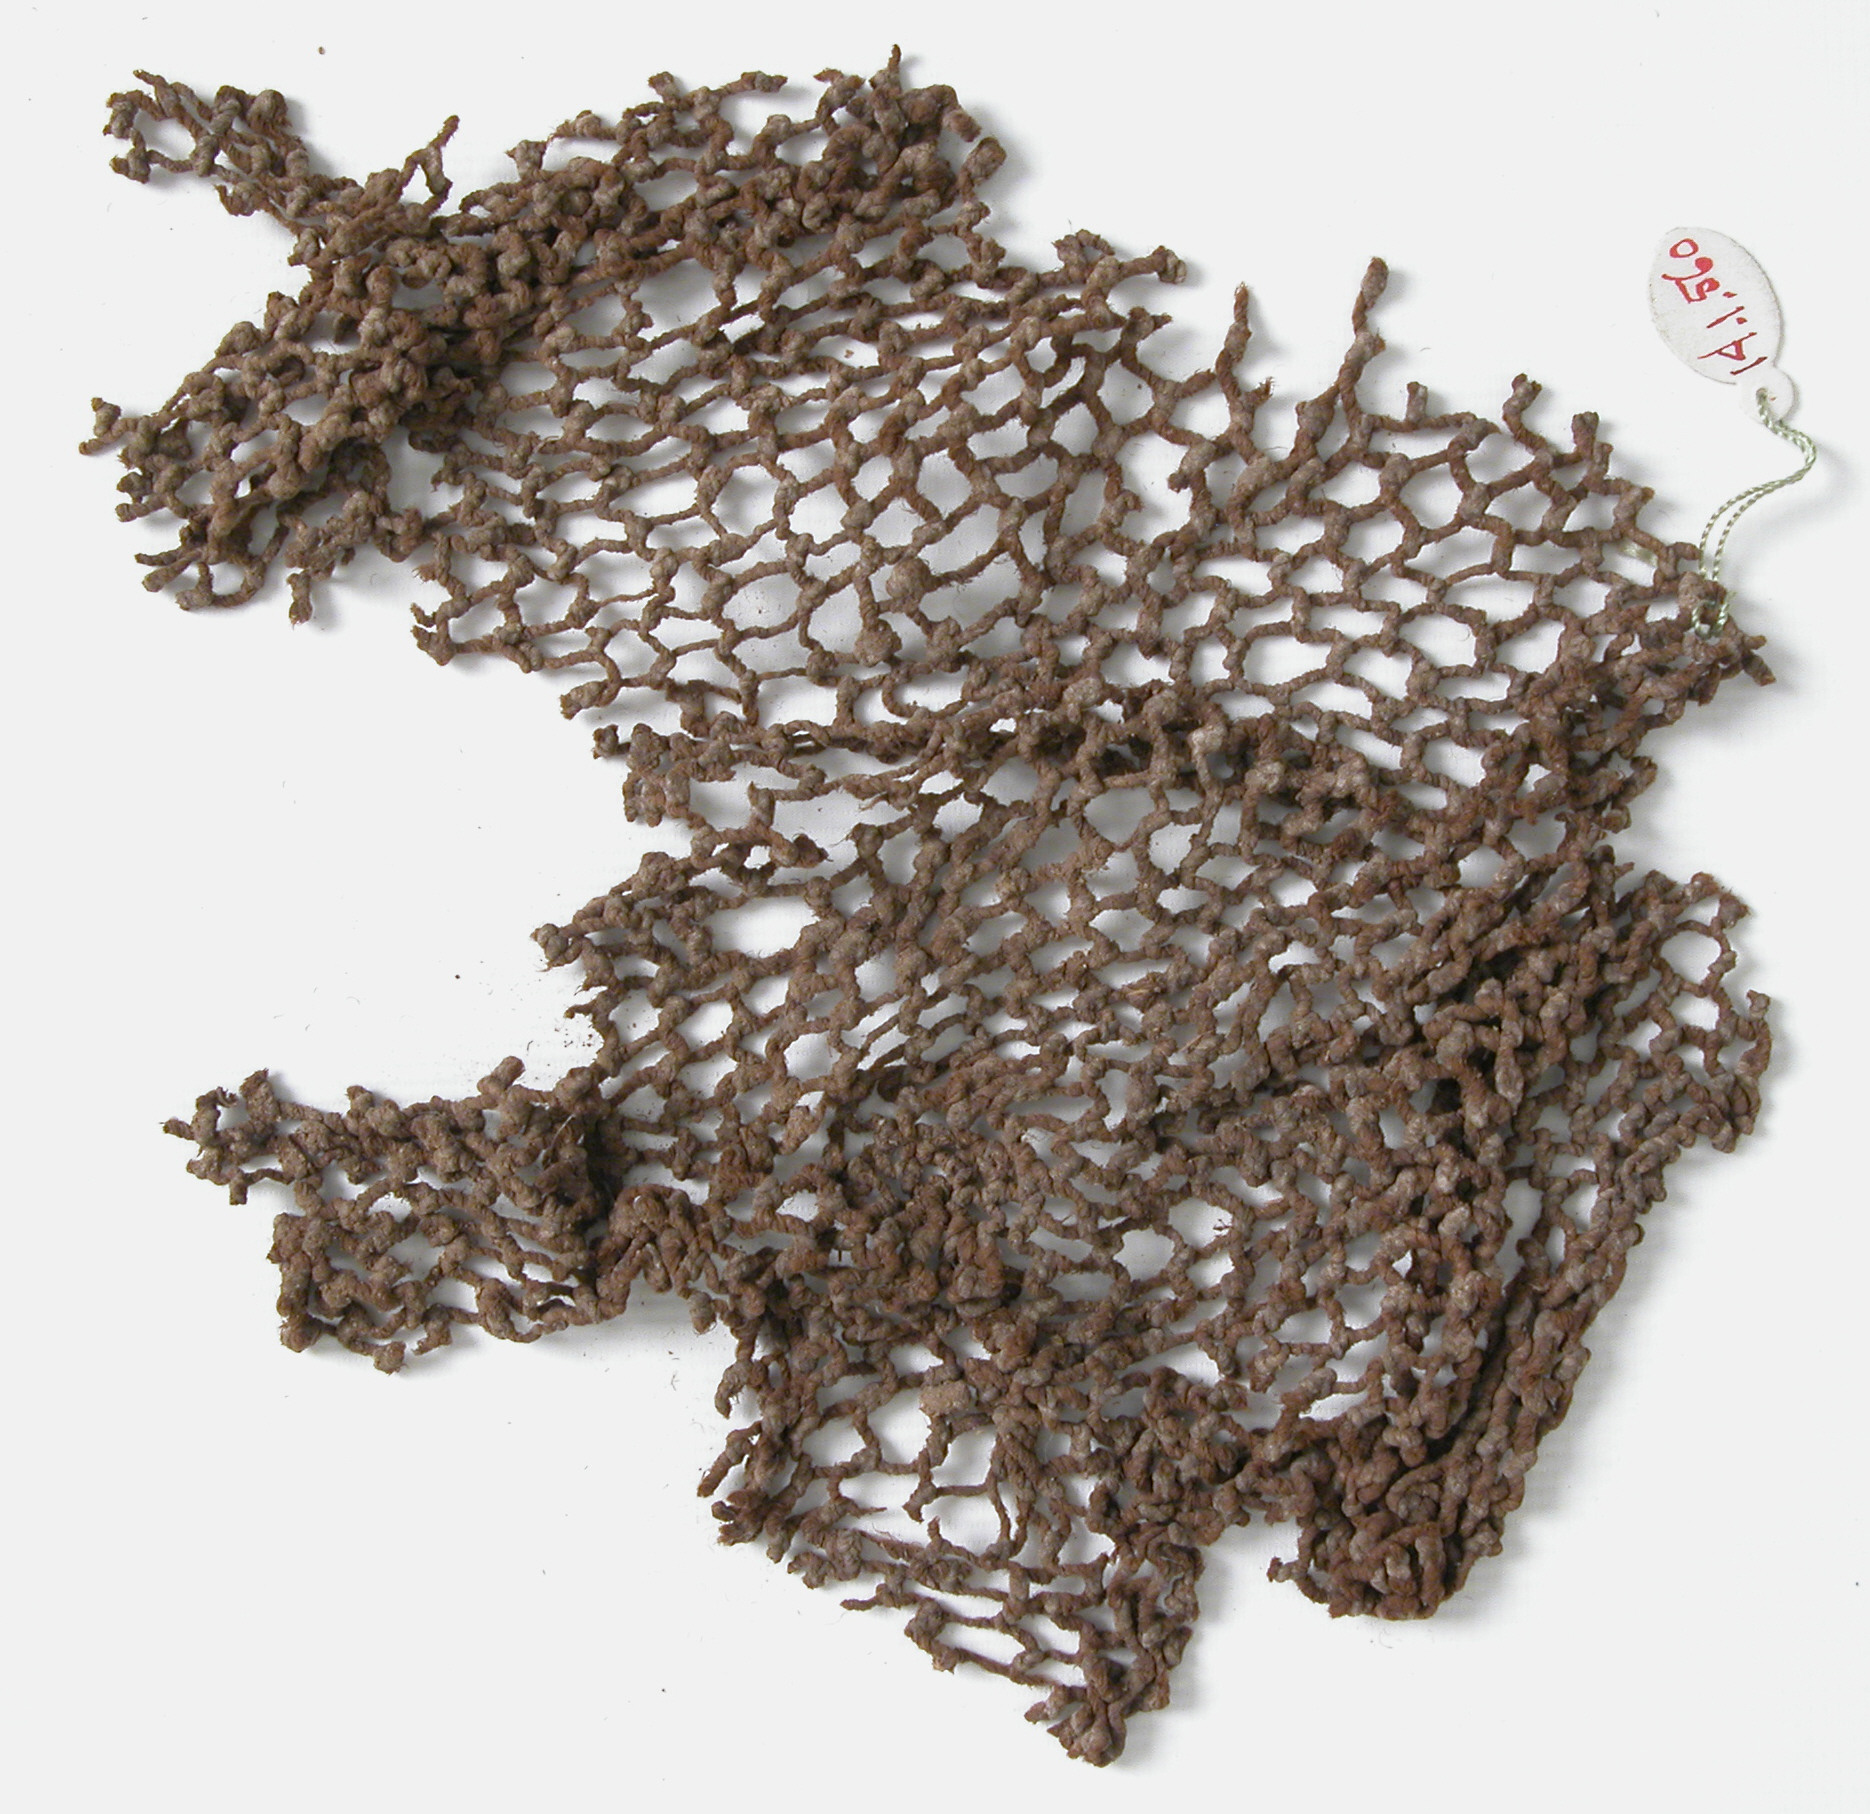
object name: fish net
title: Fish Net Fragment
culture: coptic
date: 580-640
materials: linen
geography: egypt